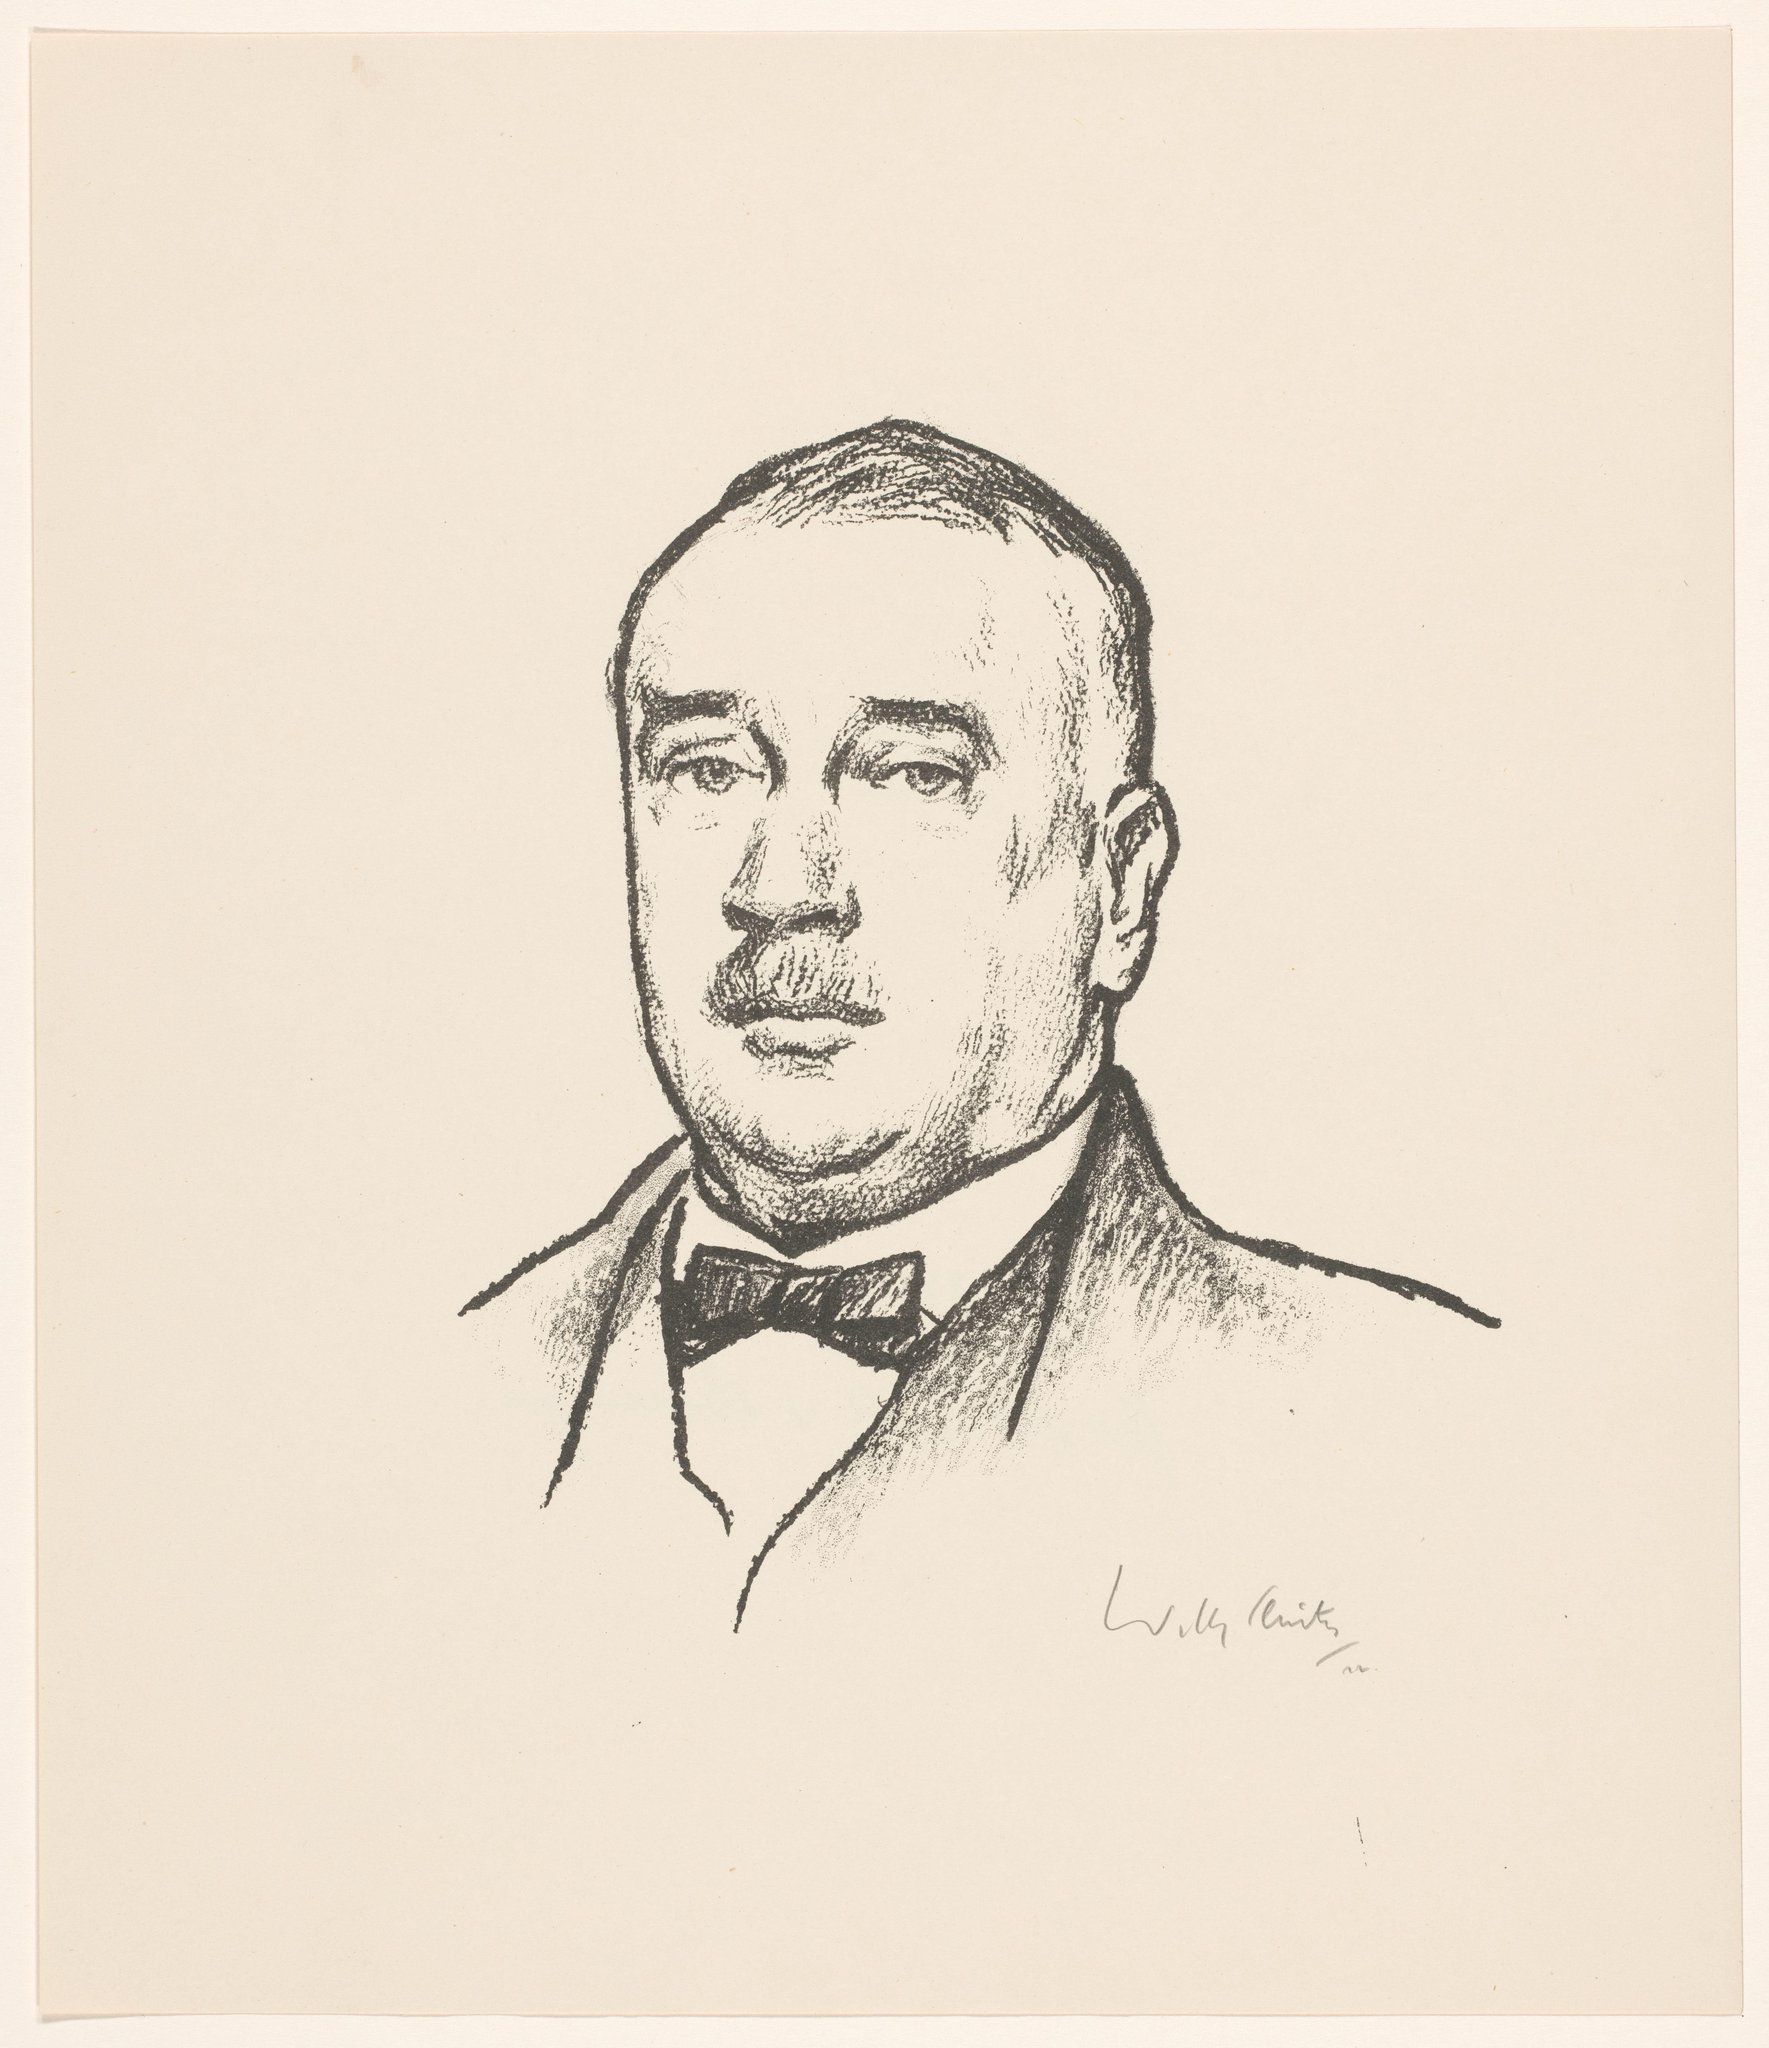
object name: print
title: Portret van Eltjo Aldegondus van Beresteyn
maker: willy sluiter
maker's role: draughtsman, painter, print maker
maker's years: 1873-1949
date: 1922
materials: paper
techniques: lithograph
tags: haarlem, the hague, politician, eeltjo aldegondus van beresteijn, historical persons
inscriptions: collector's mark: Lugt 2228